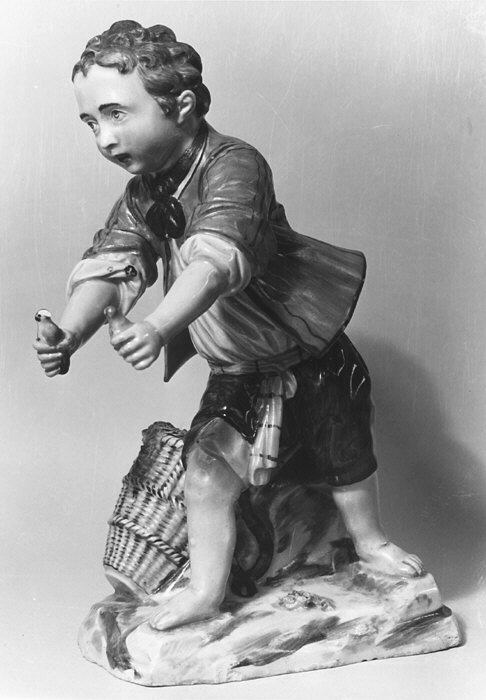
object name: figure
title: Boy holding birds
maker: ottweiler pottery and porcelain manufactory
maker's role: manufactory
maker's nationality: german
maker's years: 1763-1771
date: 1766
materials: hard paste porcelain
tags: birds,boys